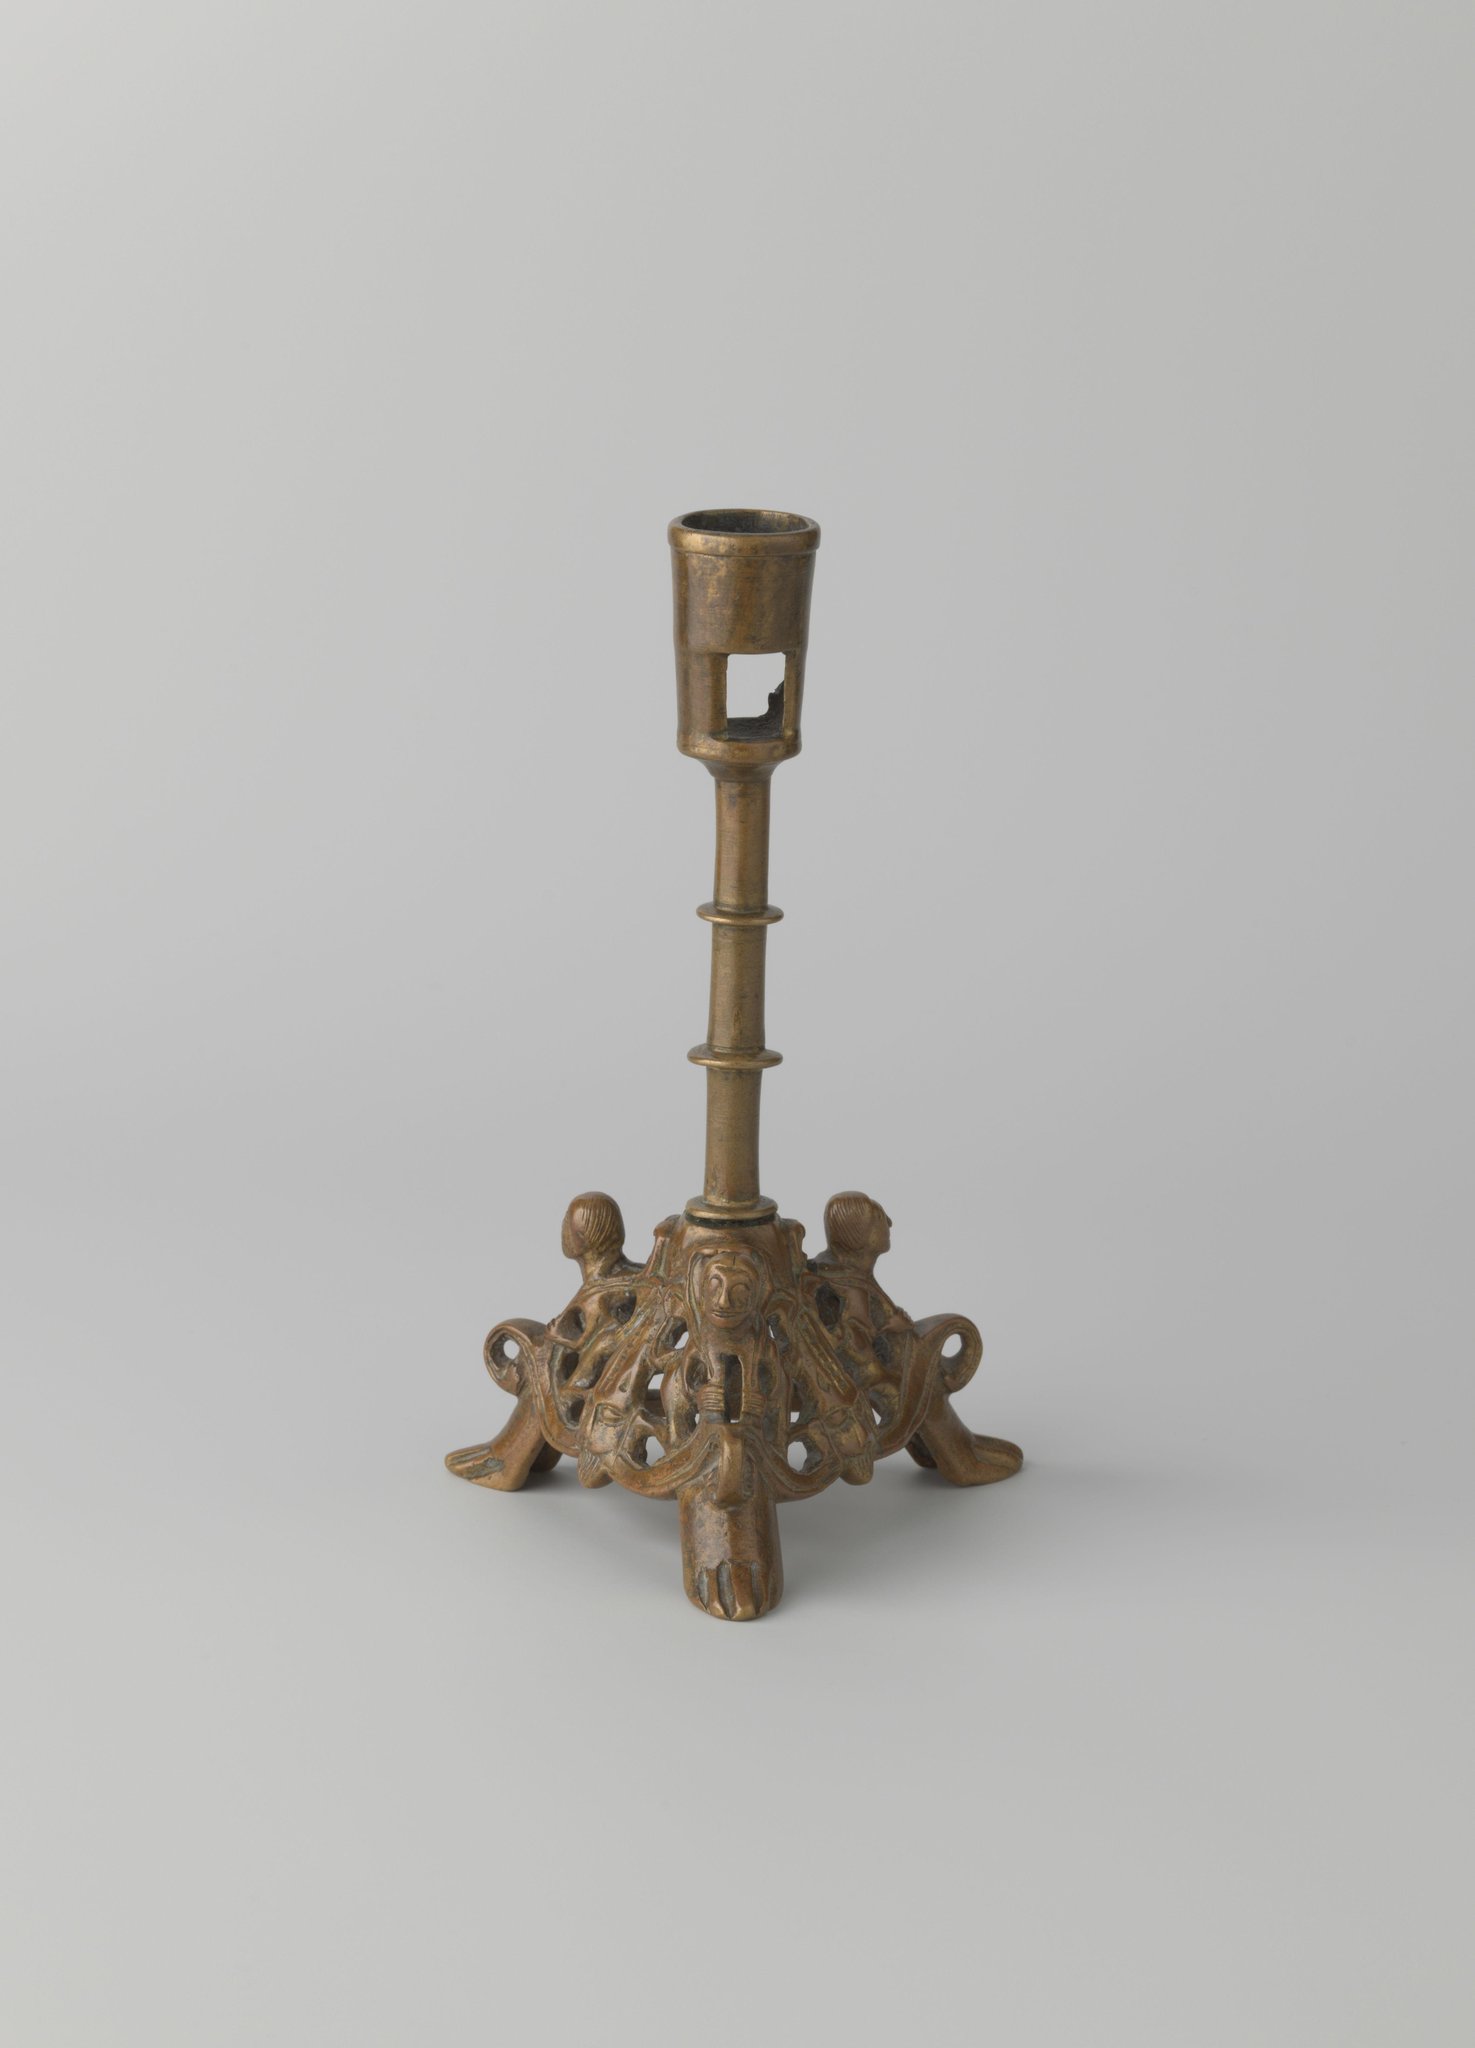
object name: candlestick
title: Kandelaar met driezijdige voet, versierd met drakenkoppen en mensfiguren temidden van ranken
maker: Anonymous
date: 1200-1300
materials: copper alloy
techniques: casting, metalworking, engraving, soldering, turning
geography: western germany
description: Candlestick. Bronze. West Germany, 13th century.